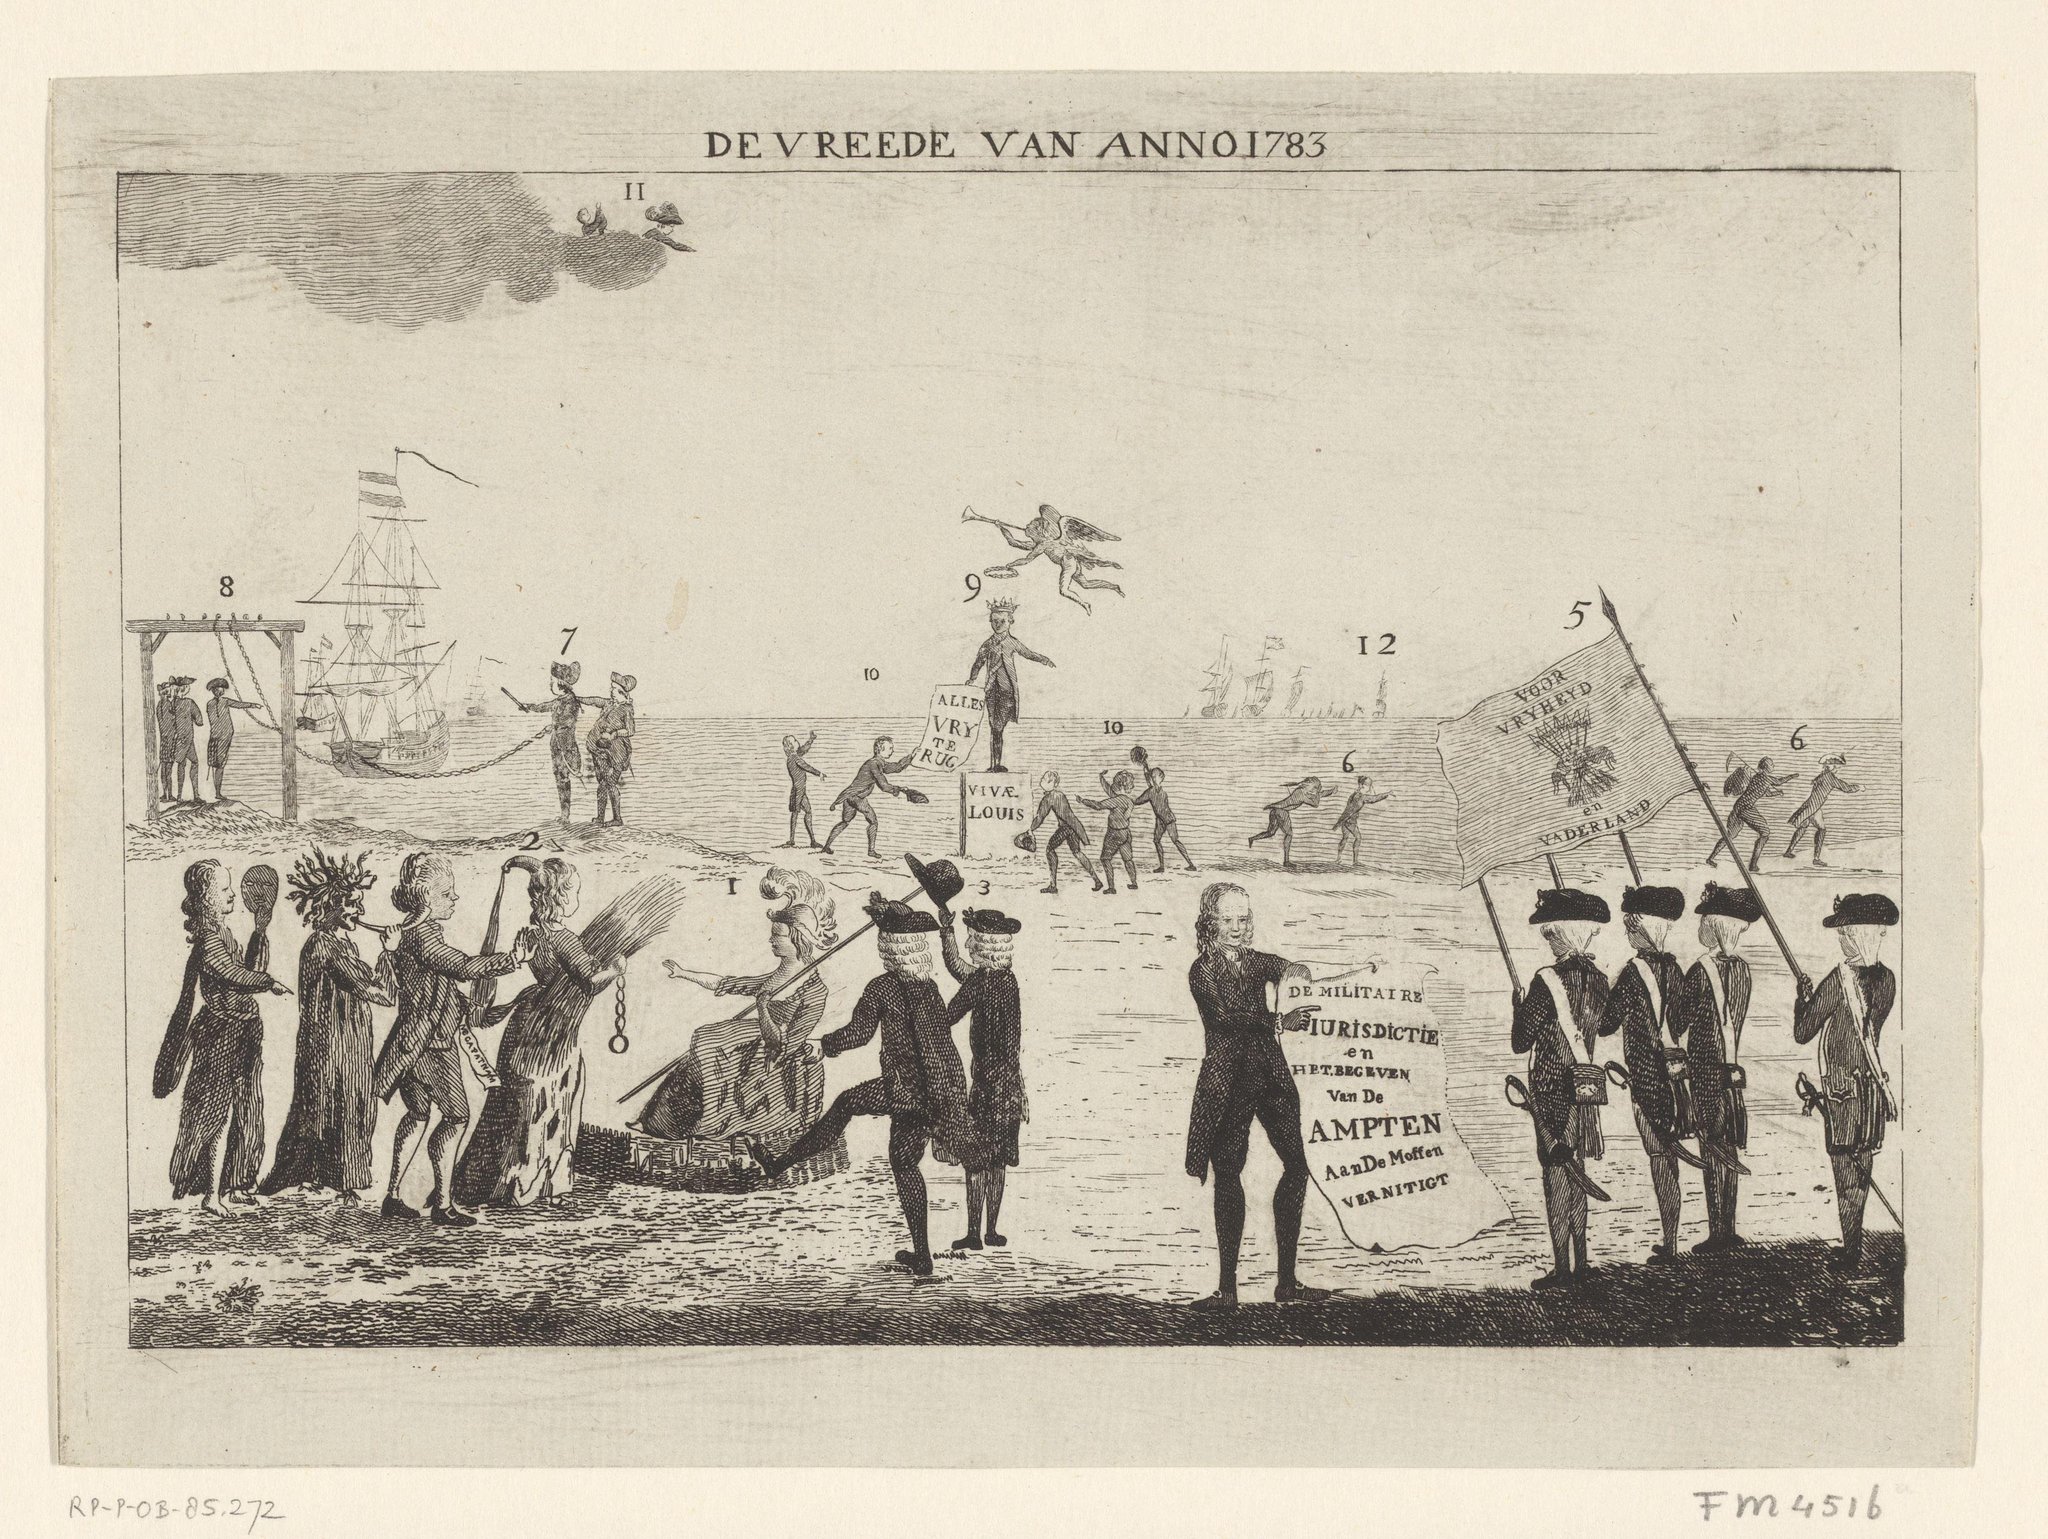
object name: print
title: De Vreede van Anno 1783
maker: Anonymous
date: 1783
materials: paper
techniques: engraving, etching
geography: northern netherlands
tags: personifications of countries, nations, states, districts, etc., fenced or walled garden; 'hortus conclusus', netherlands, fourth anglo-dutch war, patriots (1780-1795)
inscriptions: collector's mark: Lugt 2228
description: Spotprent op politieke situatie in Nederland in het jaar 1783 en een mogelijke vrede met Engeland. De Nederlandse Maagd zittend in de Hollandse Tuin die door twee predikanten kapot getrapt wordt. De Engelsman, Nijd en Valsheid drijven de berooide Vrede richting Nederland. Op de achtergrond midden wordt een standbeeld van koning Lodewijk XVI door de Faam gekroond. Rechts vooraan leden van een vrijkorps. Bij de prent behoort een tekstblad met uitleg.